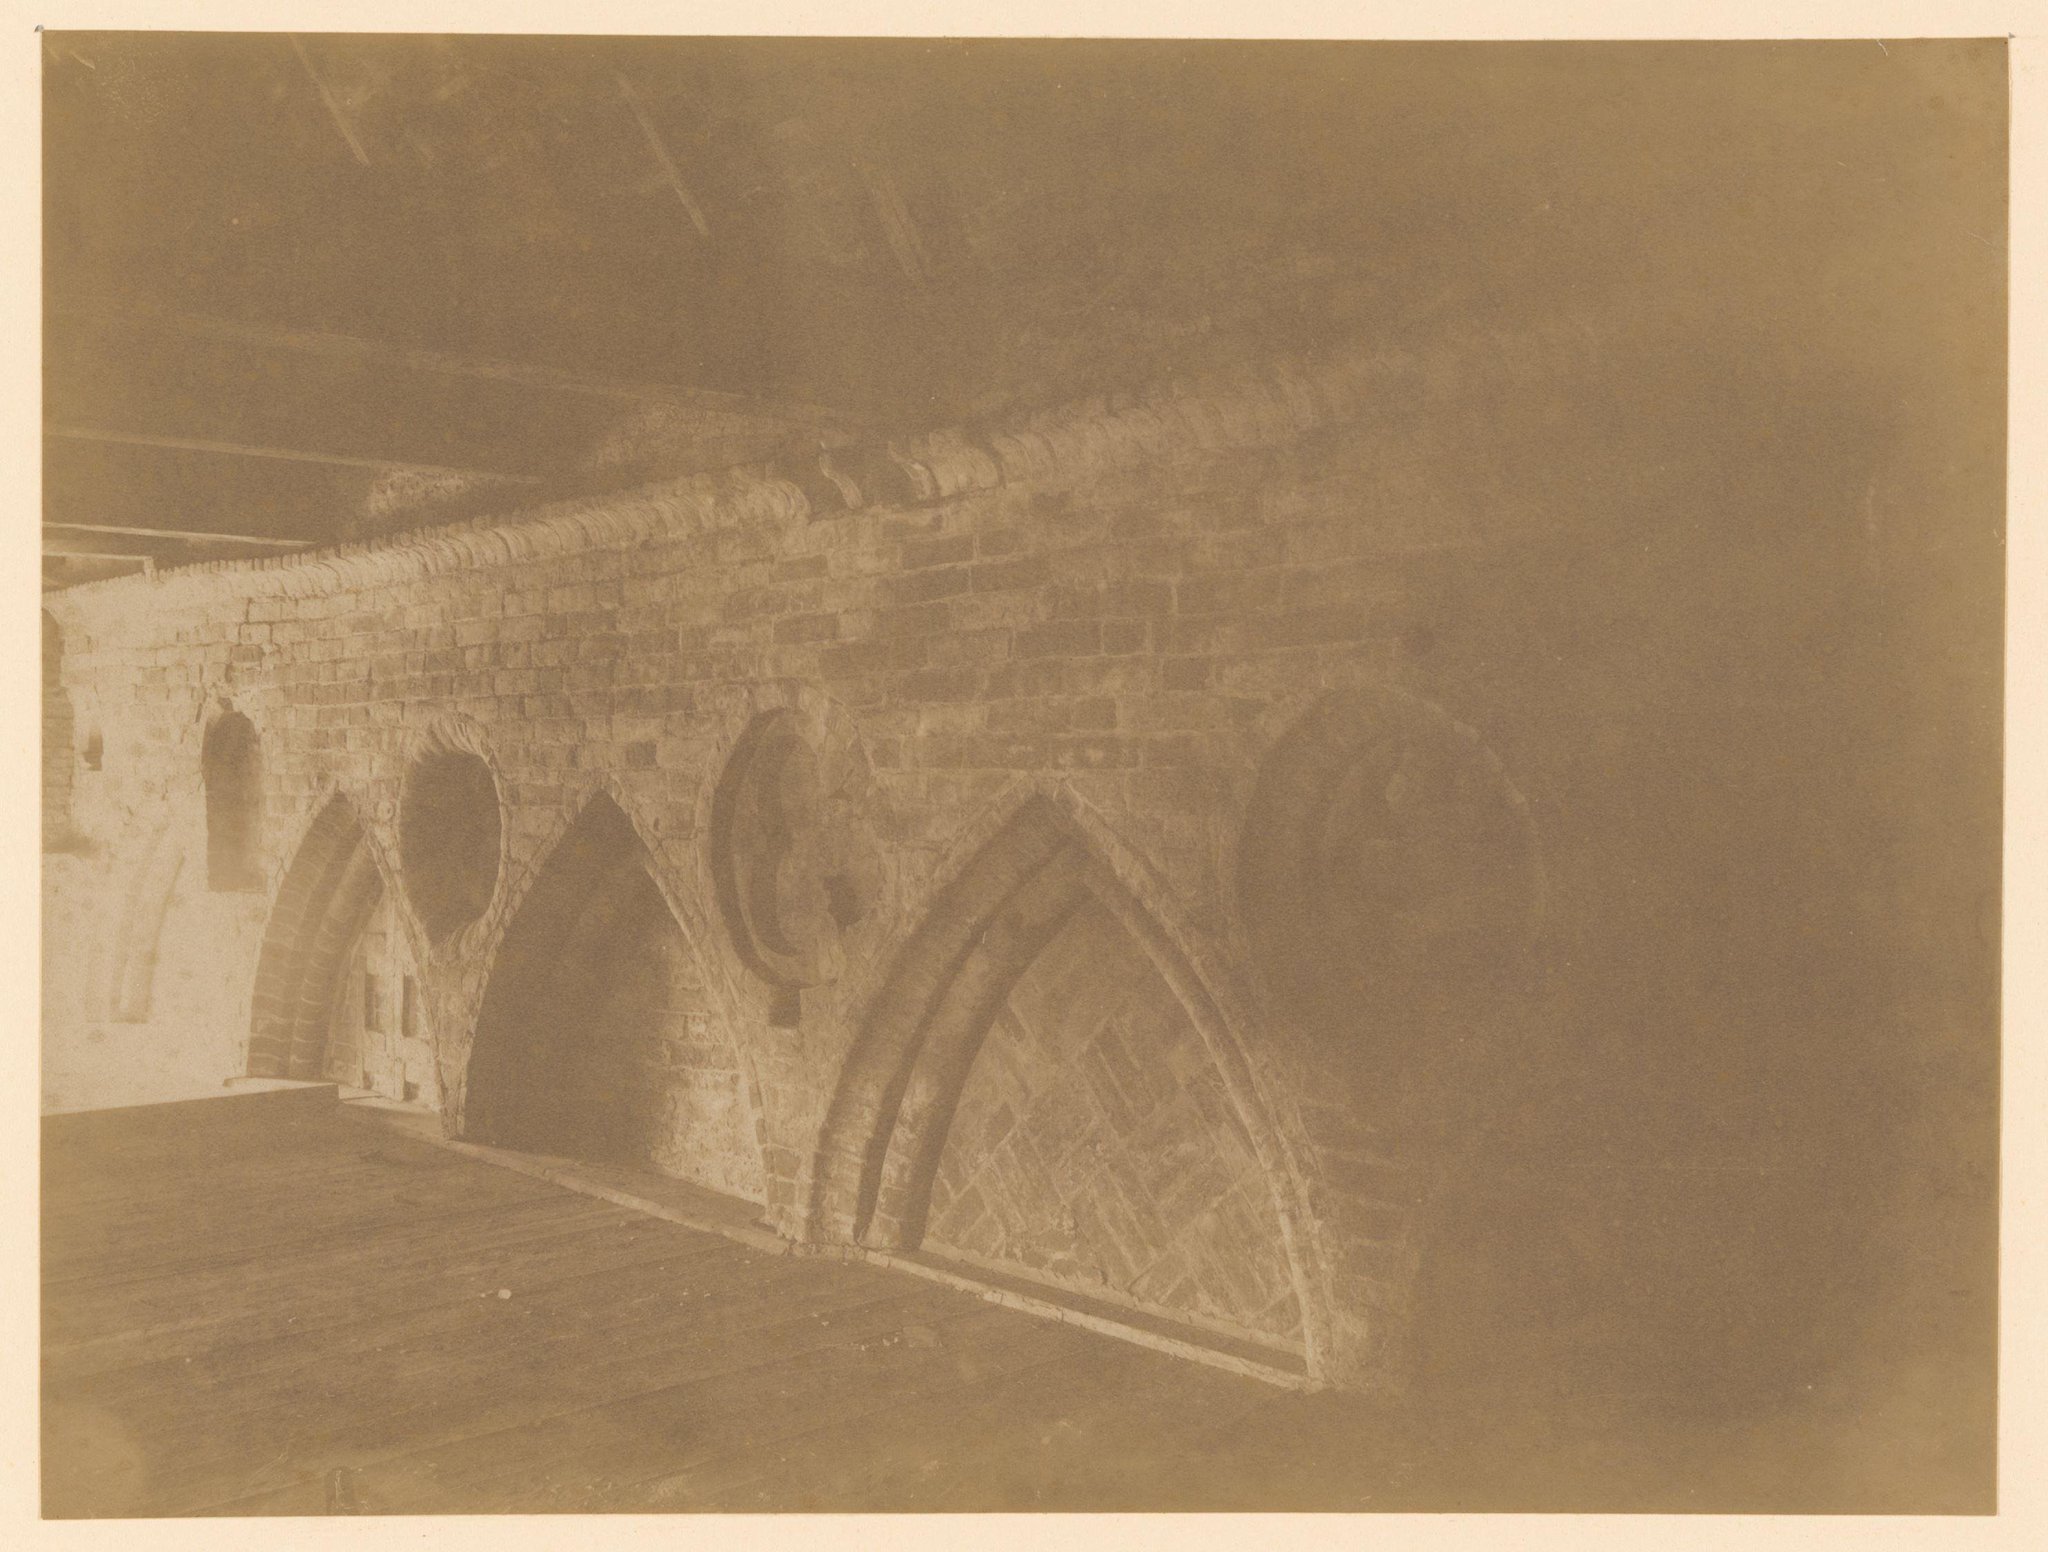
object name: photograph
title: Boogvensters en nissen in de abdijkerk te Aduard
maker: anoniem (monumentenzorg)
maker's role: fotograaf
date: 1900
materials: cardboard, photographic support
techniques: albumen print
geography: aduard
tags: parts of church interior: niche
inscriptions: annotation: ‘Aduard’, annotation: ‘Aduard (Gr.)/ Boogvensters en nissen ten westen der N.H. kerk/ en boven voormaligen school/ juni 1900’